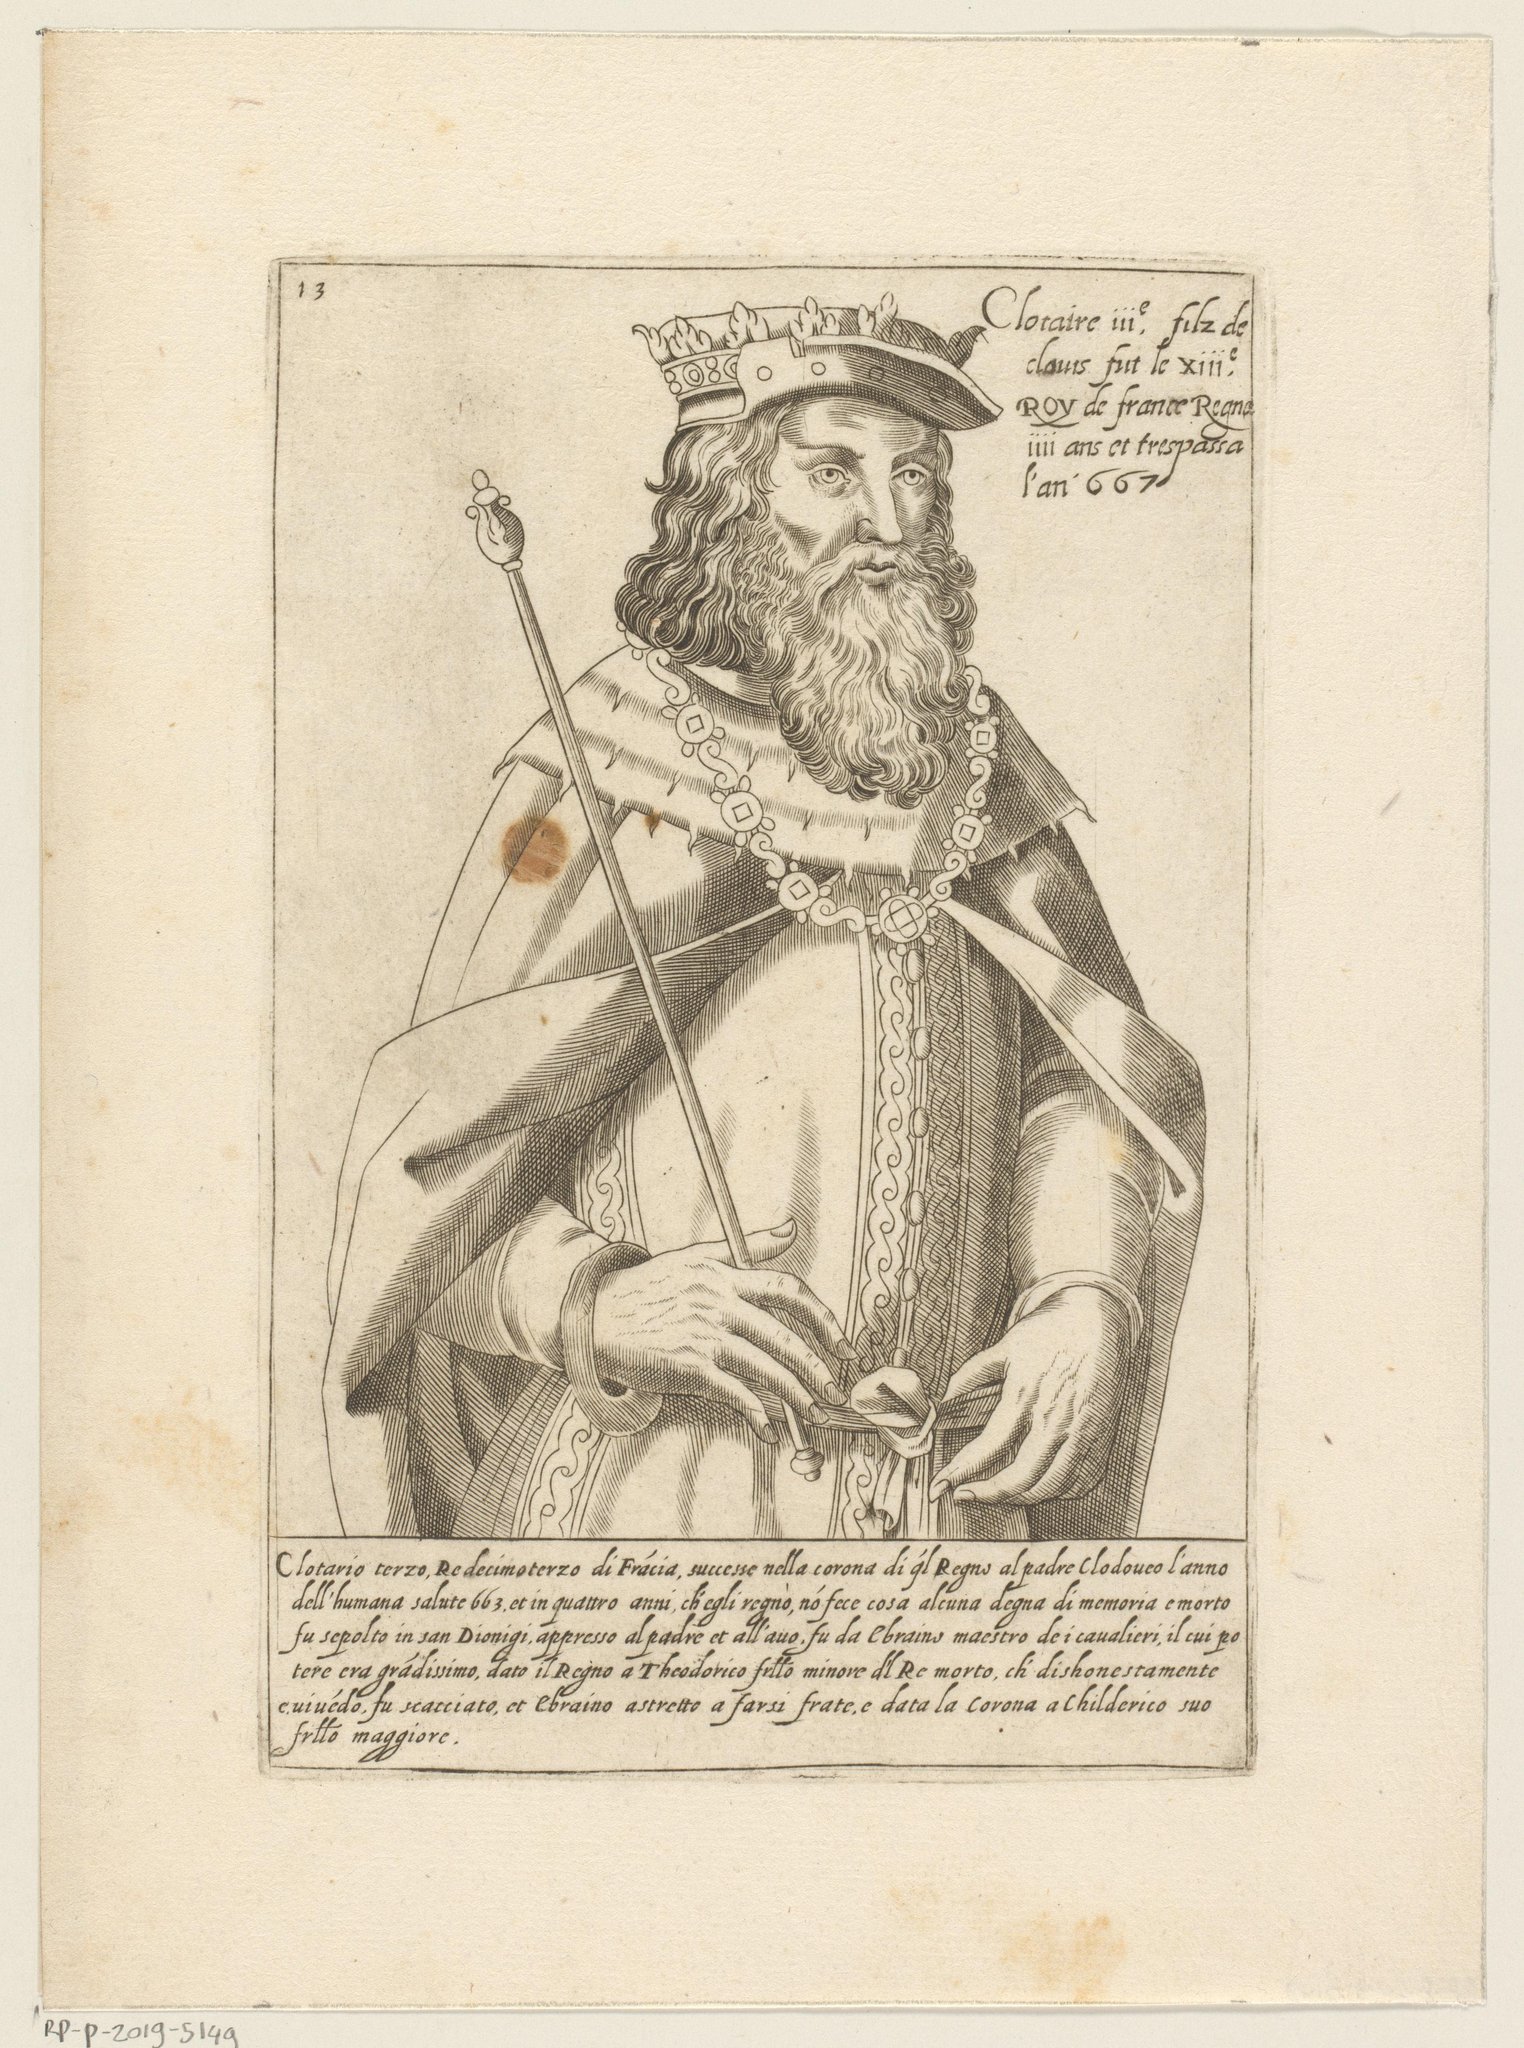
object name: print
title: Portret van Chlotharius III, koning van Neustrië en Bourgondië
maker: Anonymous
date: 1588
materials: paper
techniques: engraving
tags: crown (symbol of sovereignty), sceptre, staff (symbol of sovereignty), historical persons, king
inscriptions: watermark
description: Prent voor het eerst gebruikt in: Cronica Breve de i fatti illustri de're di Francia, con le loro effigie dal naturale cominciando da Faramondo (...). Venetië: Bernardo Giunti, 1588. Prent in ieder geval ook gebruikt in de editie van 1590 en mogelijk ook in een Franse uitgave van 1597.